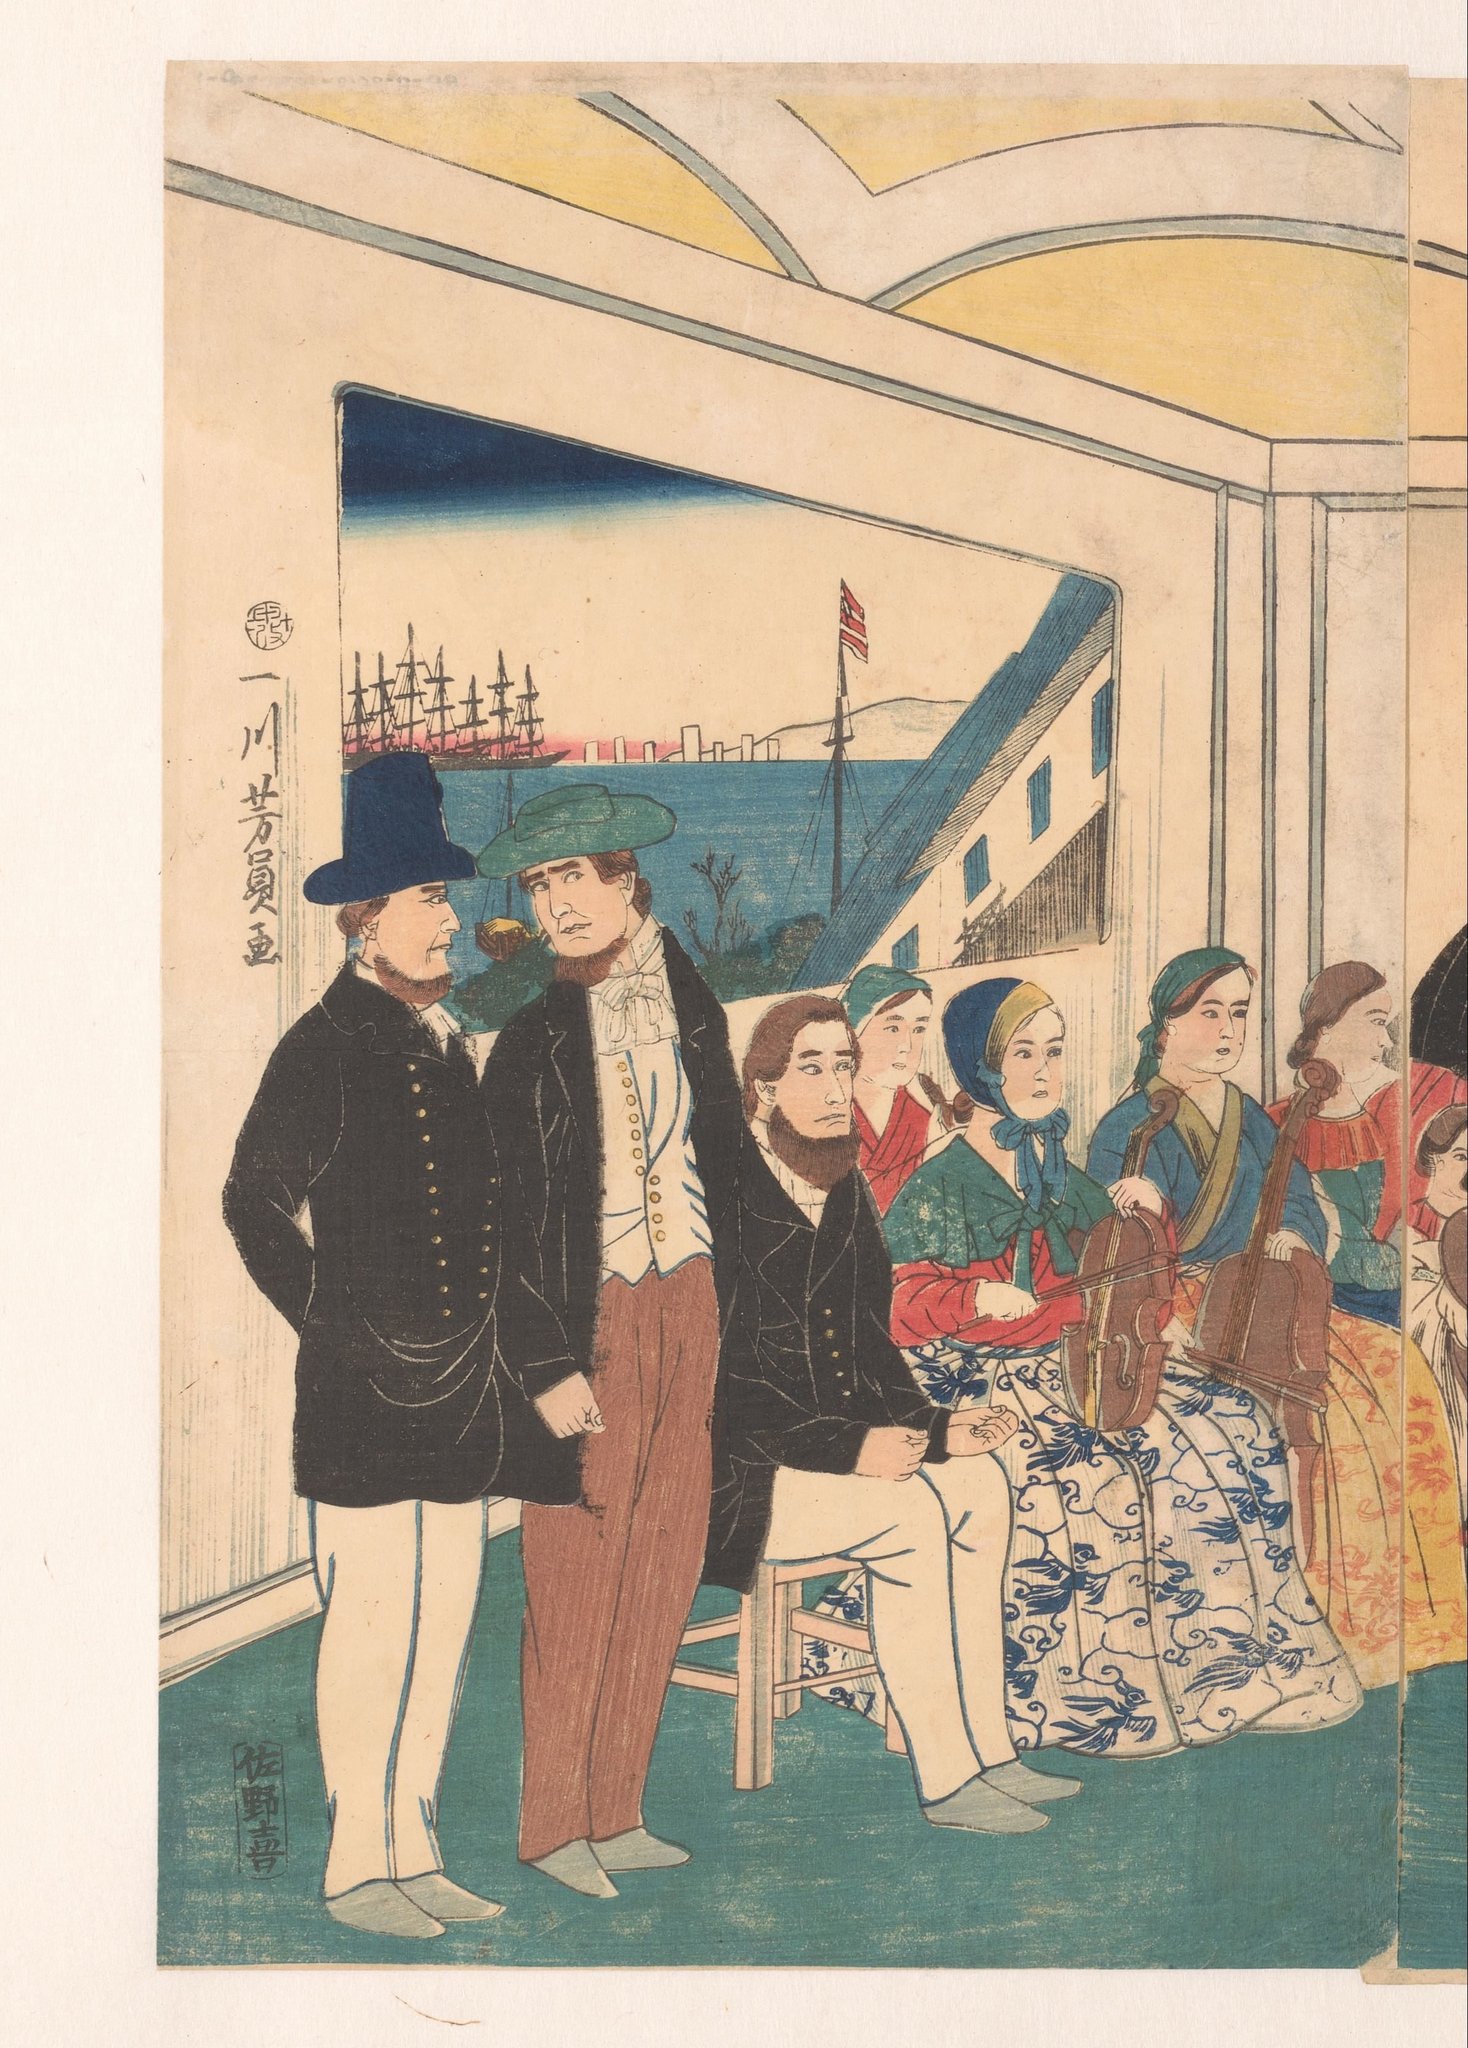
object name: print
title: Buitenlanders vermaken zich tijdens een banket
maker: utagawa yoshikazu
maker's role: print maker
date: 1812-1860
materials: paper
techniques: woodcut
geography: tokyo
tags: visiting; receiving guests; elegant company, celebration meal, feast, banquet, human races; peoples; nationalities